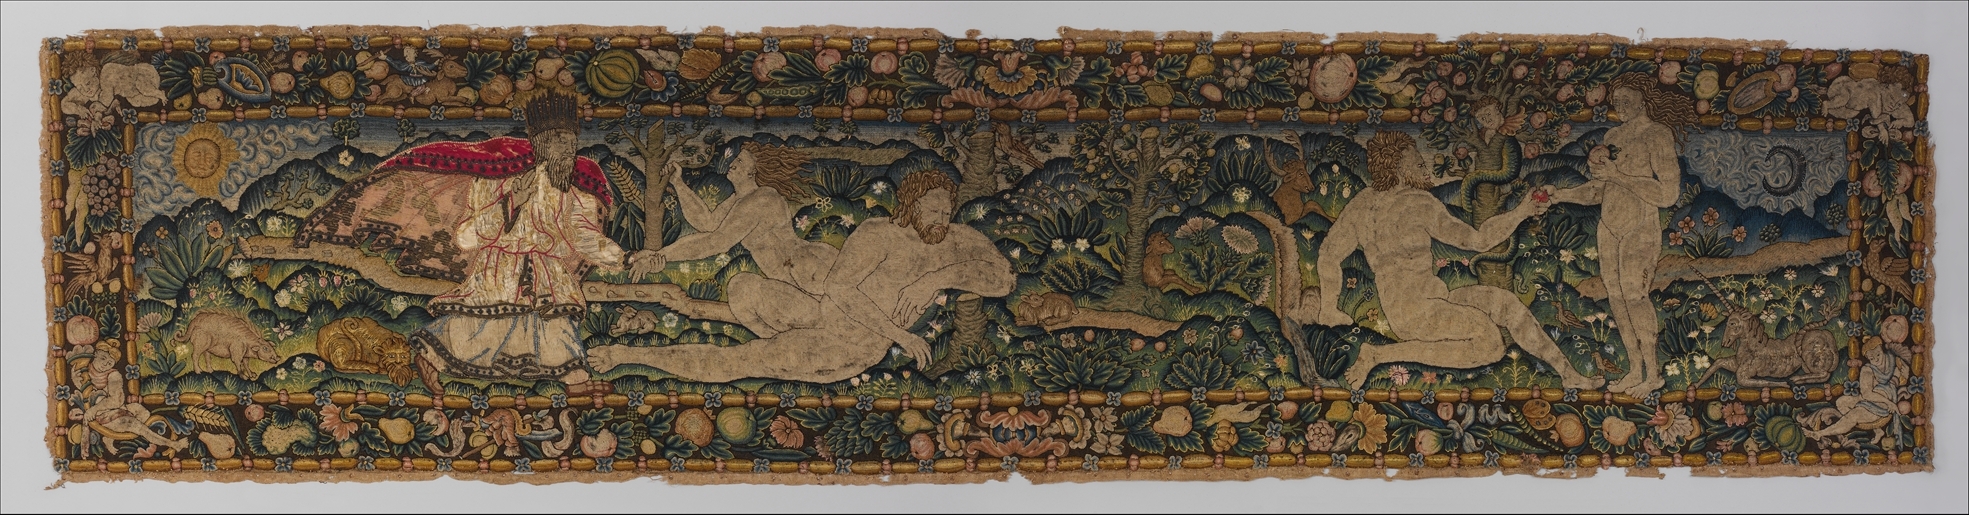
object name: bed valance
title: The Creation of Eve and The Temptation (one of a set of three)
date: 1567-1600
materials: canvas, metal thread, silk, wool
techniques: stitching, weave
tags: animals,apples,snakes,flowers,adam,eve